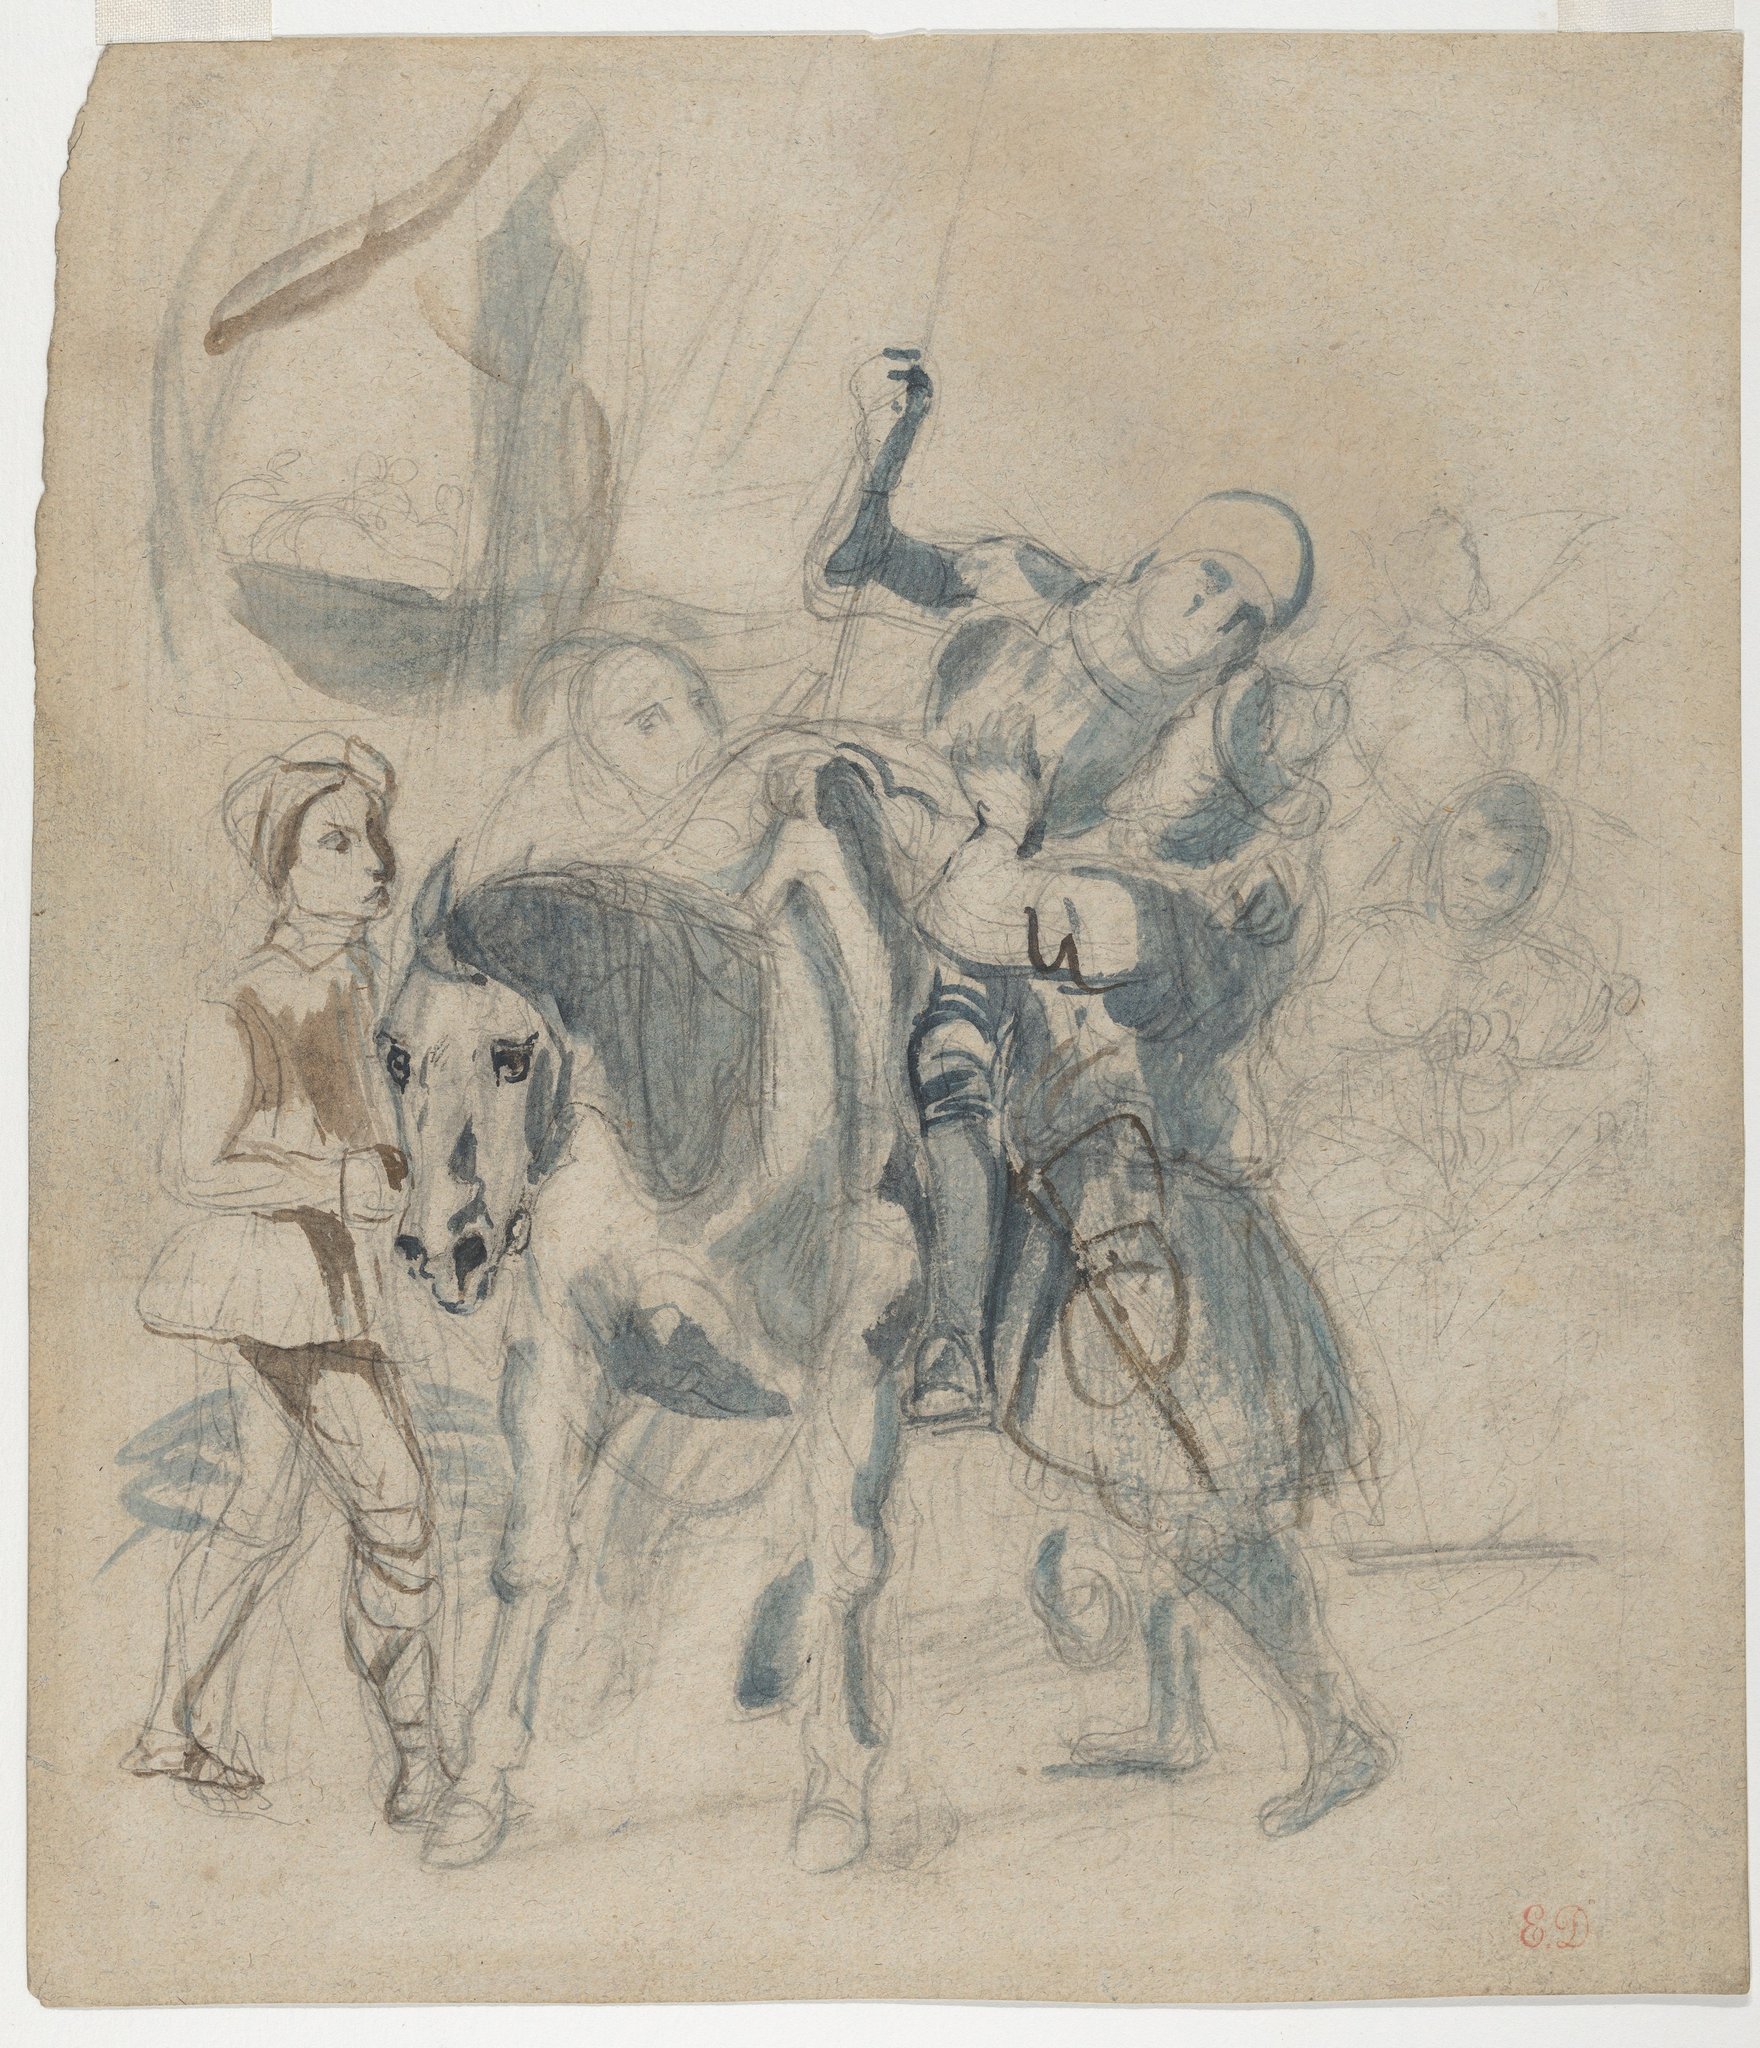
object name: drawing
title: The Wounded Goetz von Berlichingen Takes Refuge in a Gypsy Camp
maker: eugène delacroix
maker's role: artist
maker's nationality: french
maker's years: 1798-1863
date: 1836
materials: graphite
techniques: brush, wash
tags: men,horses